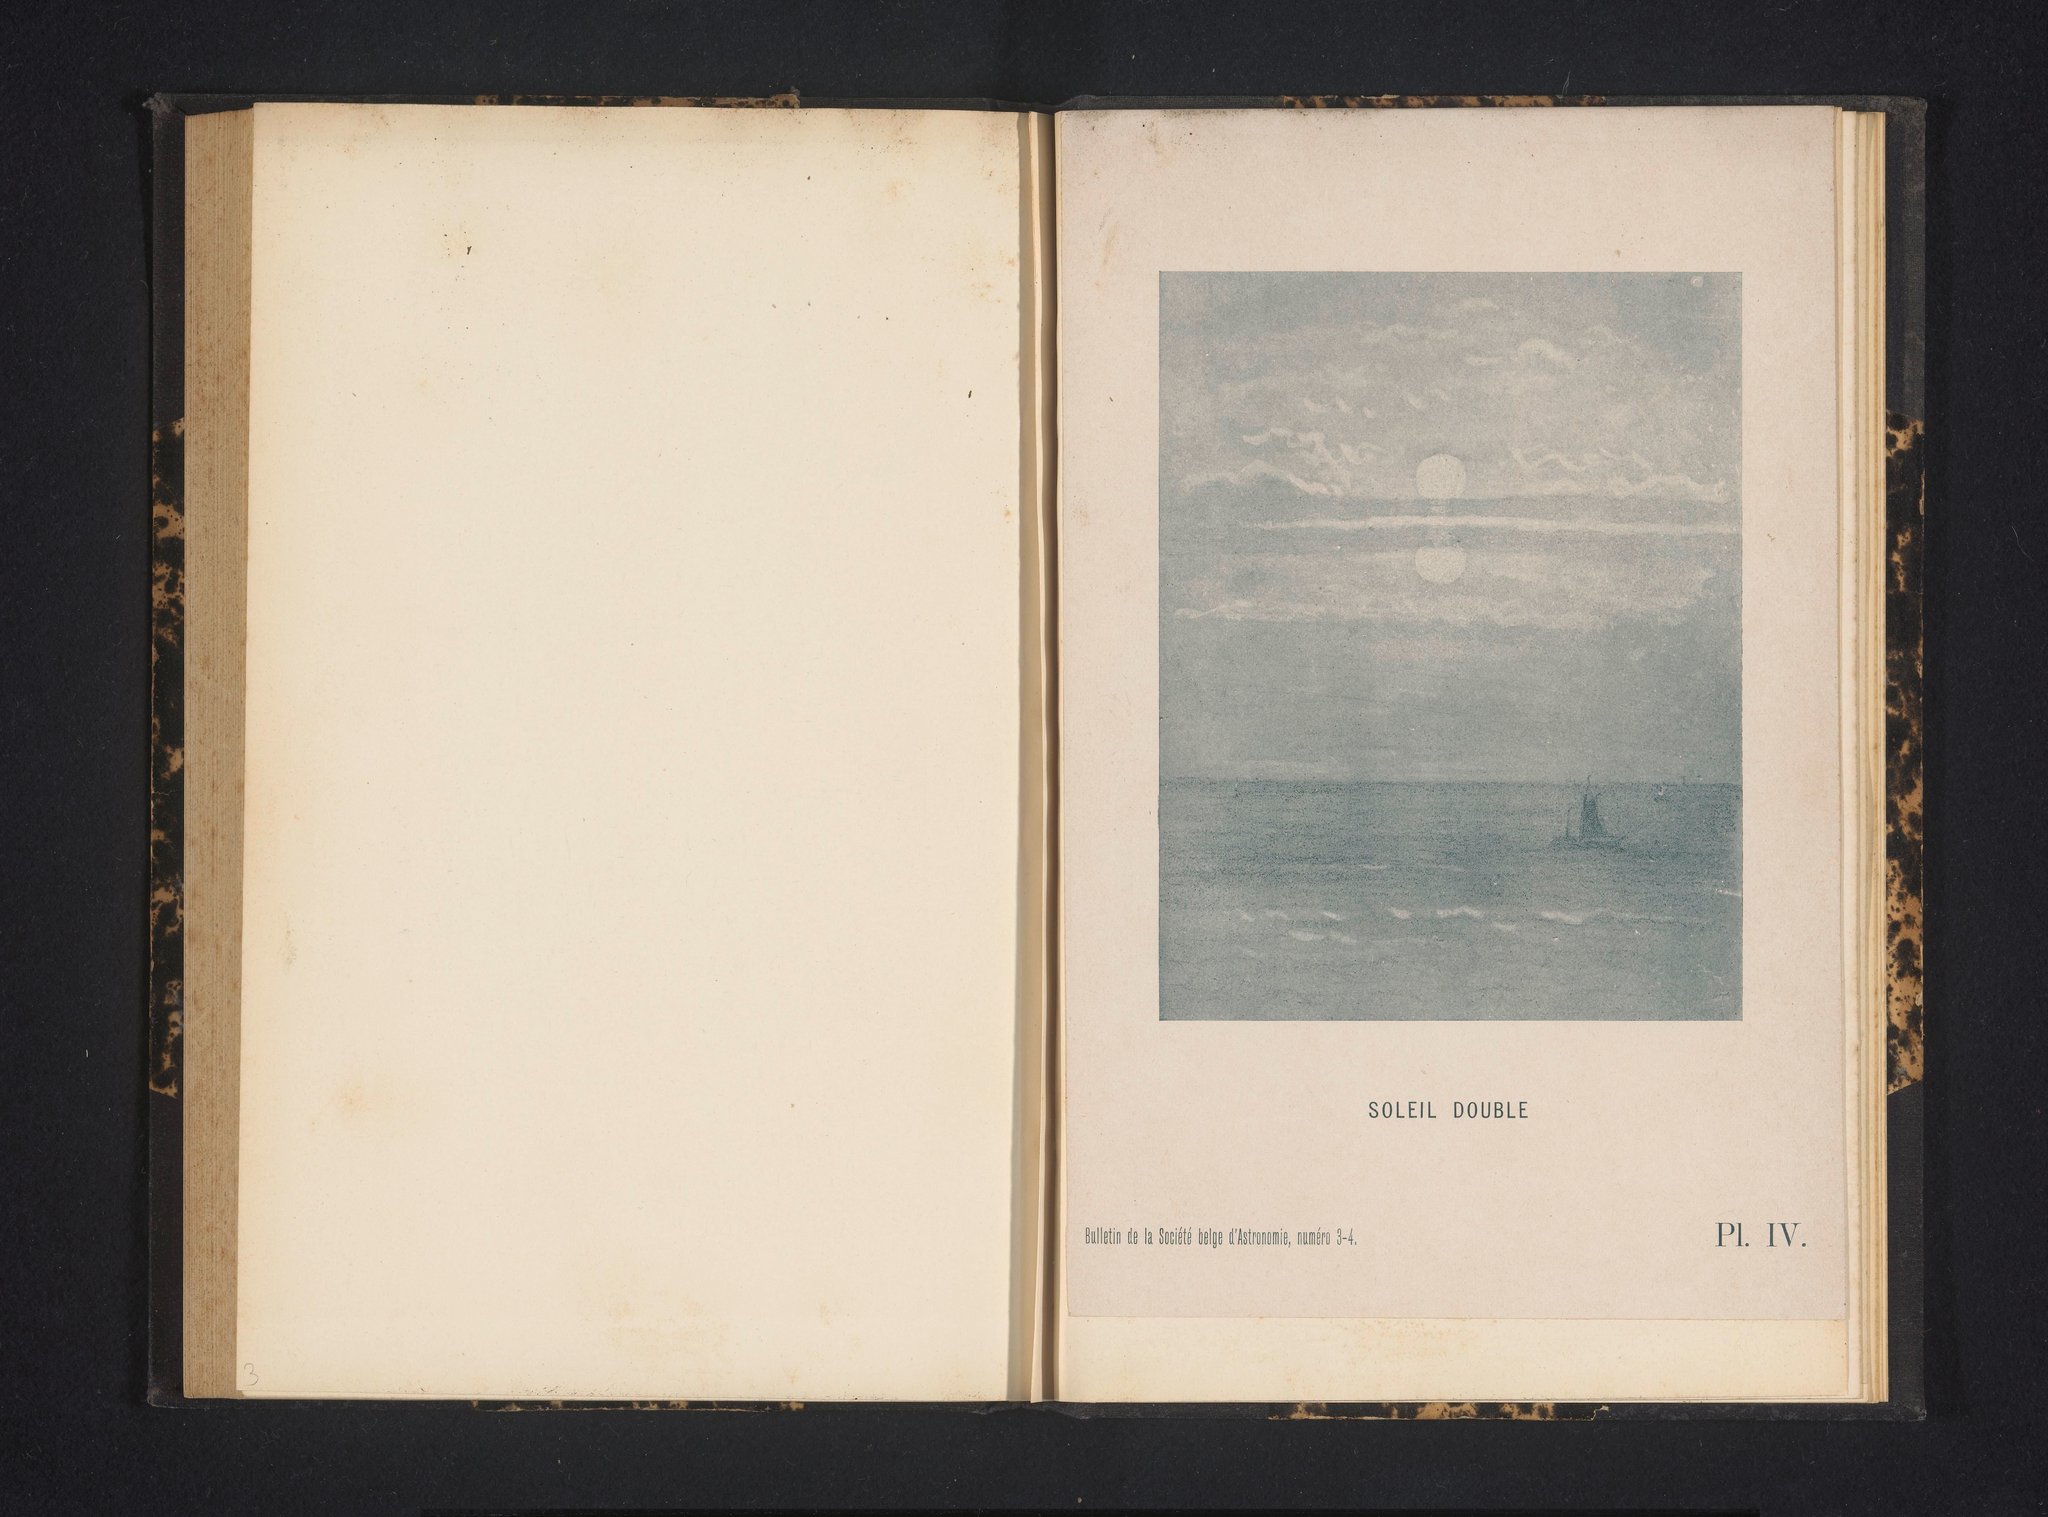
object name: page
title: Soleil Double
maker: Anonymous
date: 1890-1896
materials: paper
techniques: autotype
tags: landscapes with waters, waterscapes, seascapes (in the temperate zone), sun as celestial body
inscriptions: inscription: ‘Bulletin de la Societé belge d'Astronomie, número 1-2 Pl IV.’